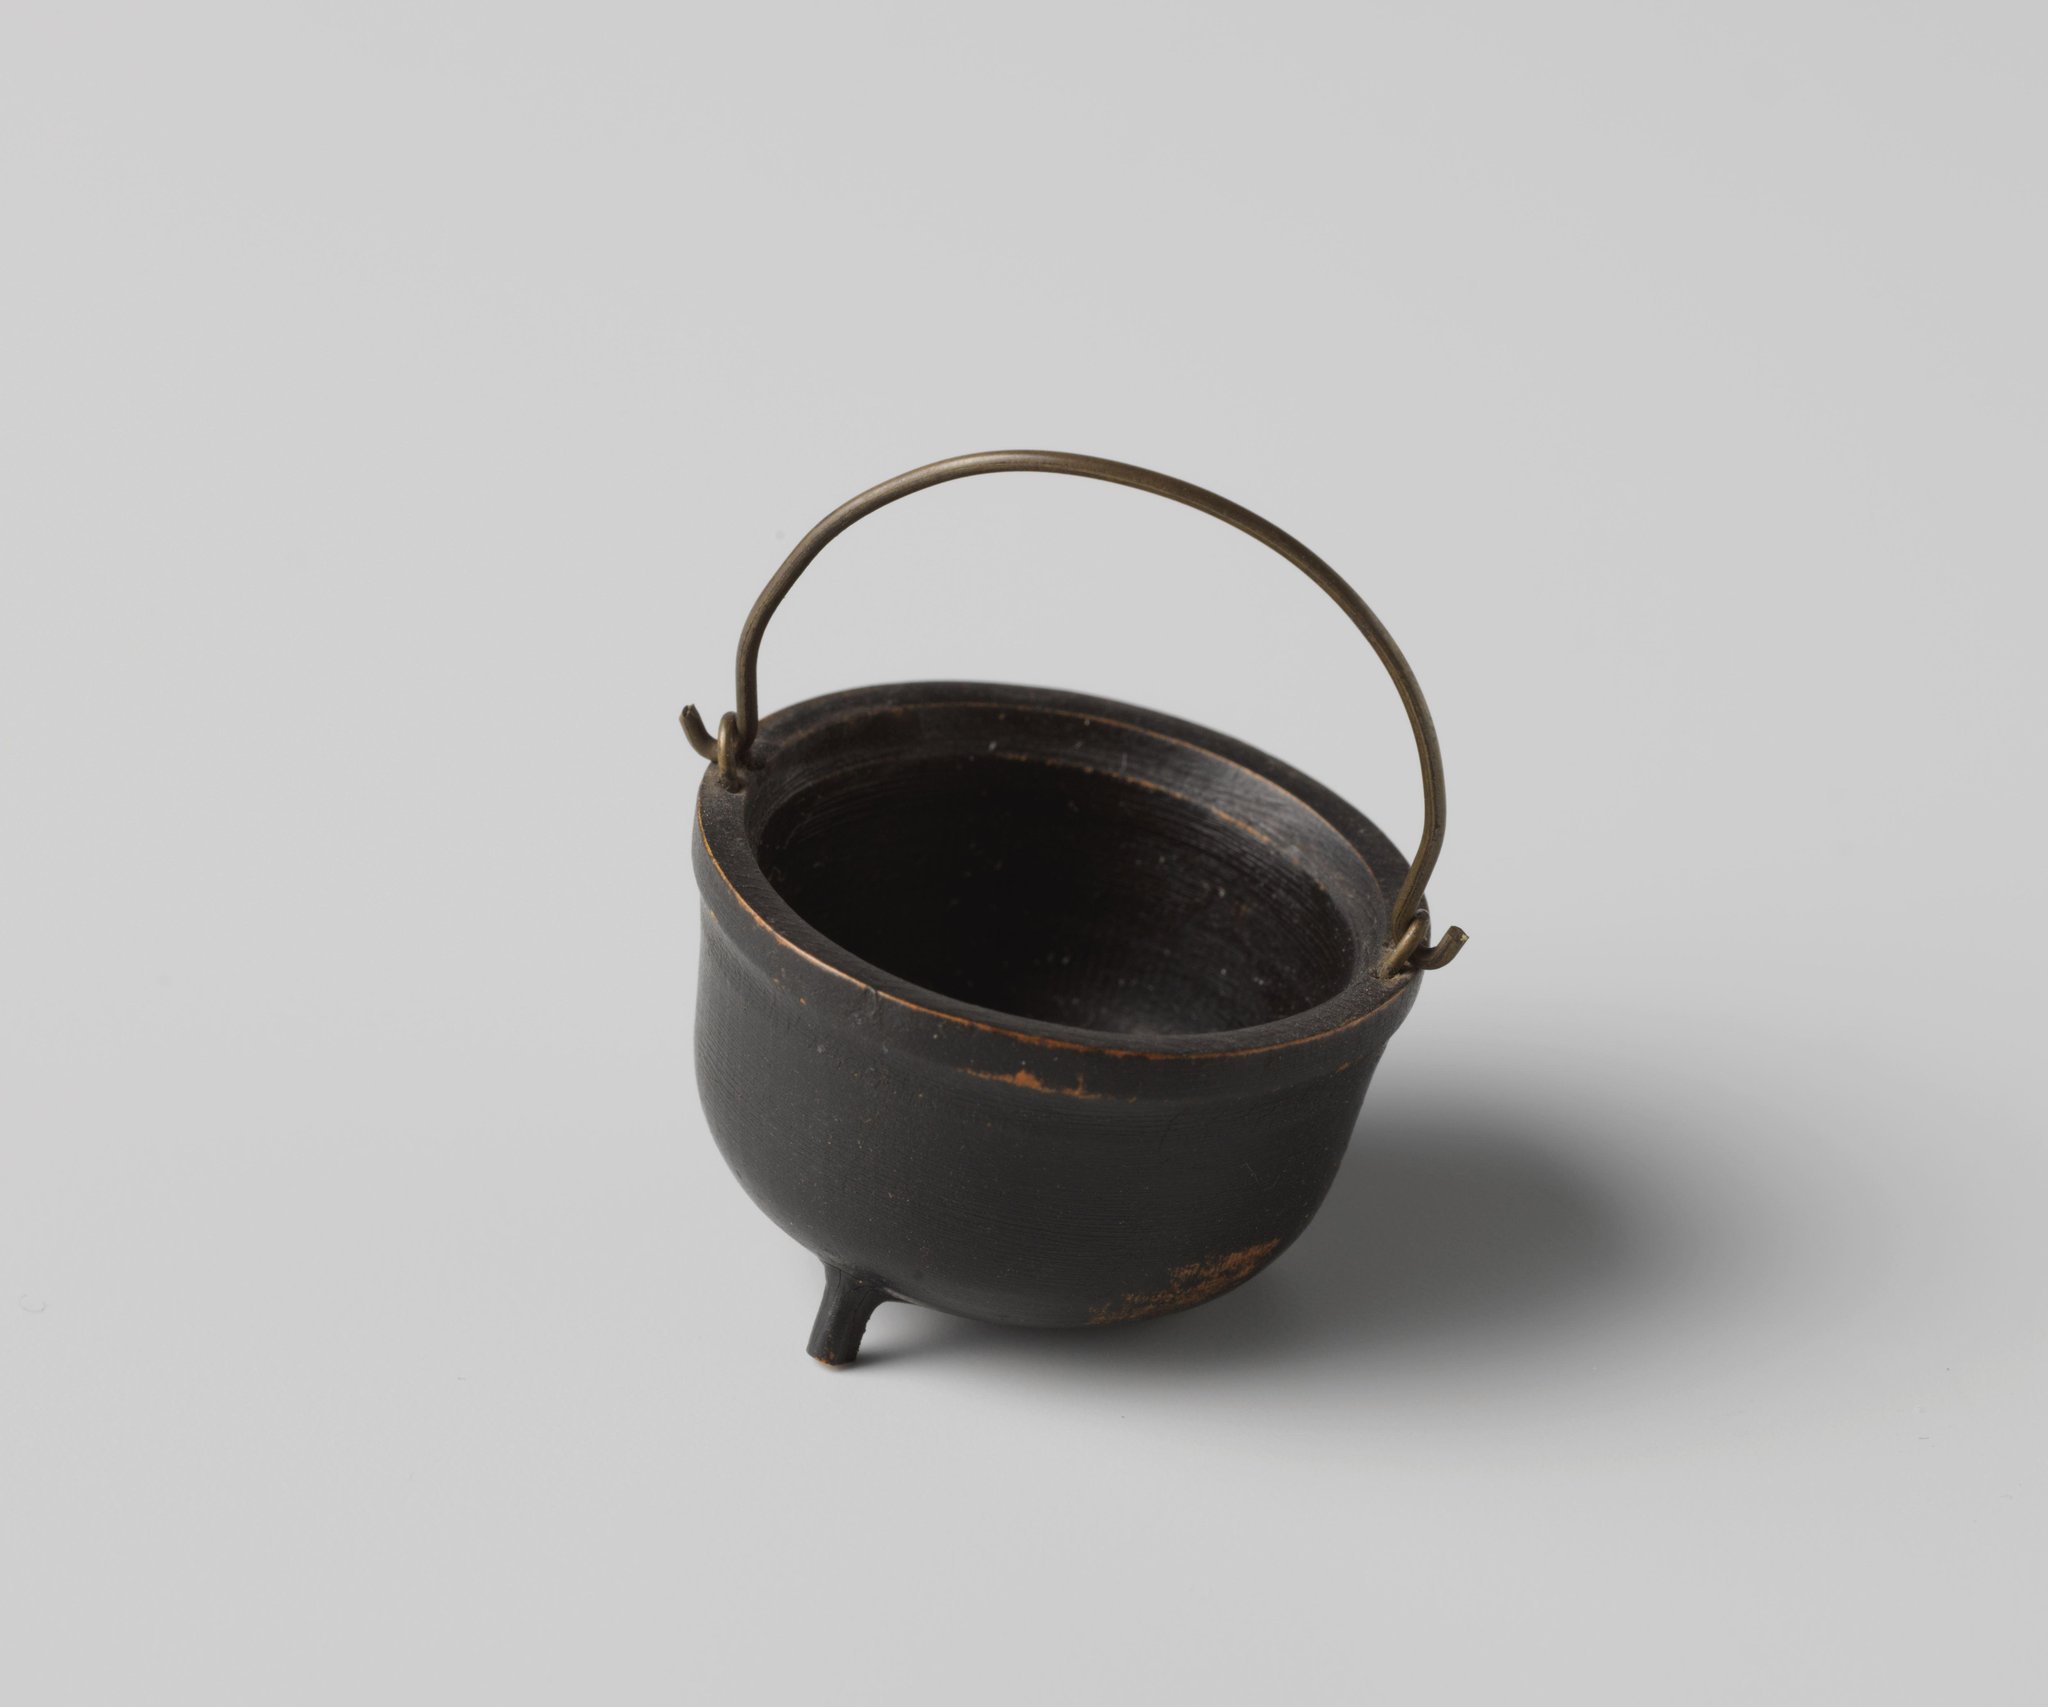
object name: cauldron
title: Kookpot met koperen hengsel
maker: Anonymous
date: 1675-1700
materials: copper, wood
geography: amsterdam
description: Kookpot, gedraaid van zwart beschilderd hout, op drie pootjes en met een hengsel van koperdraad.